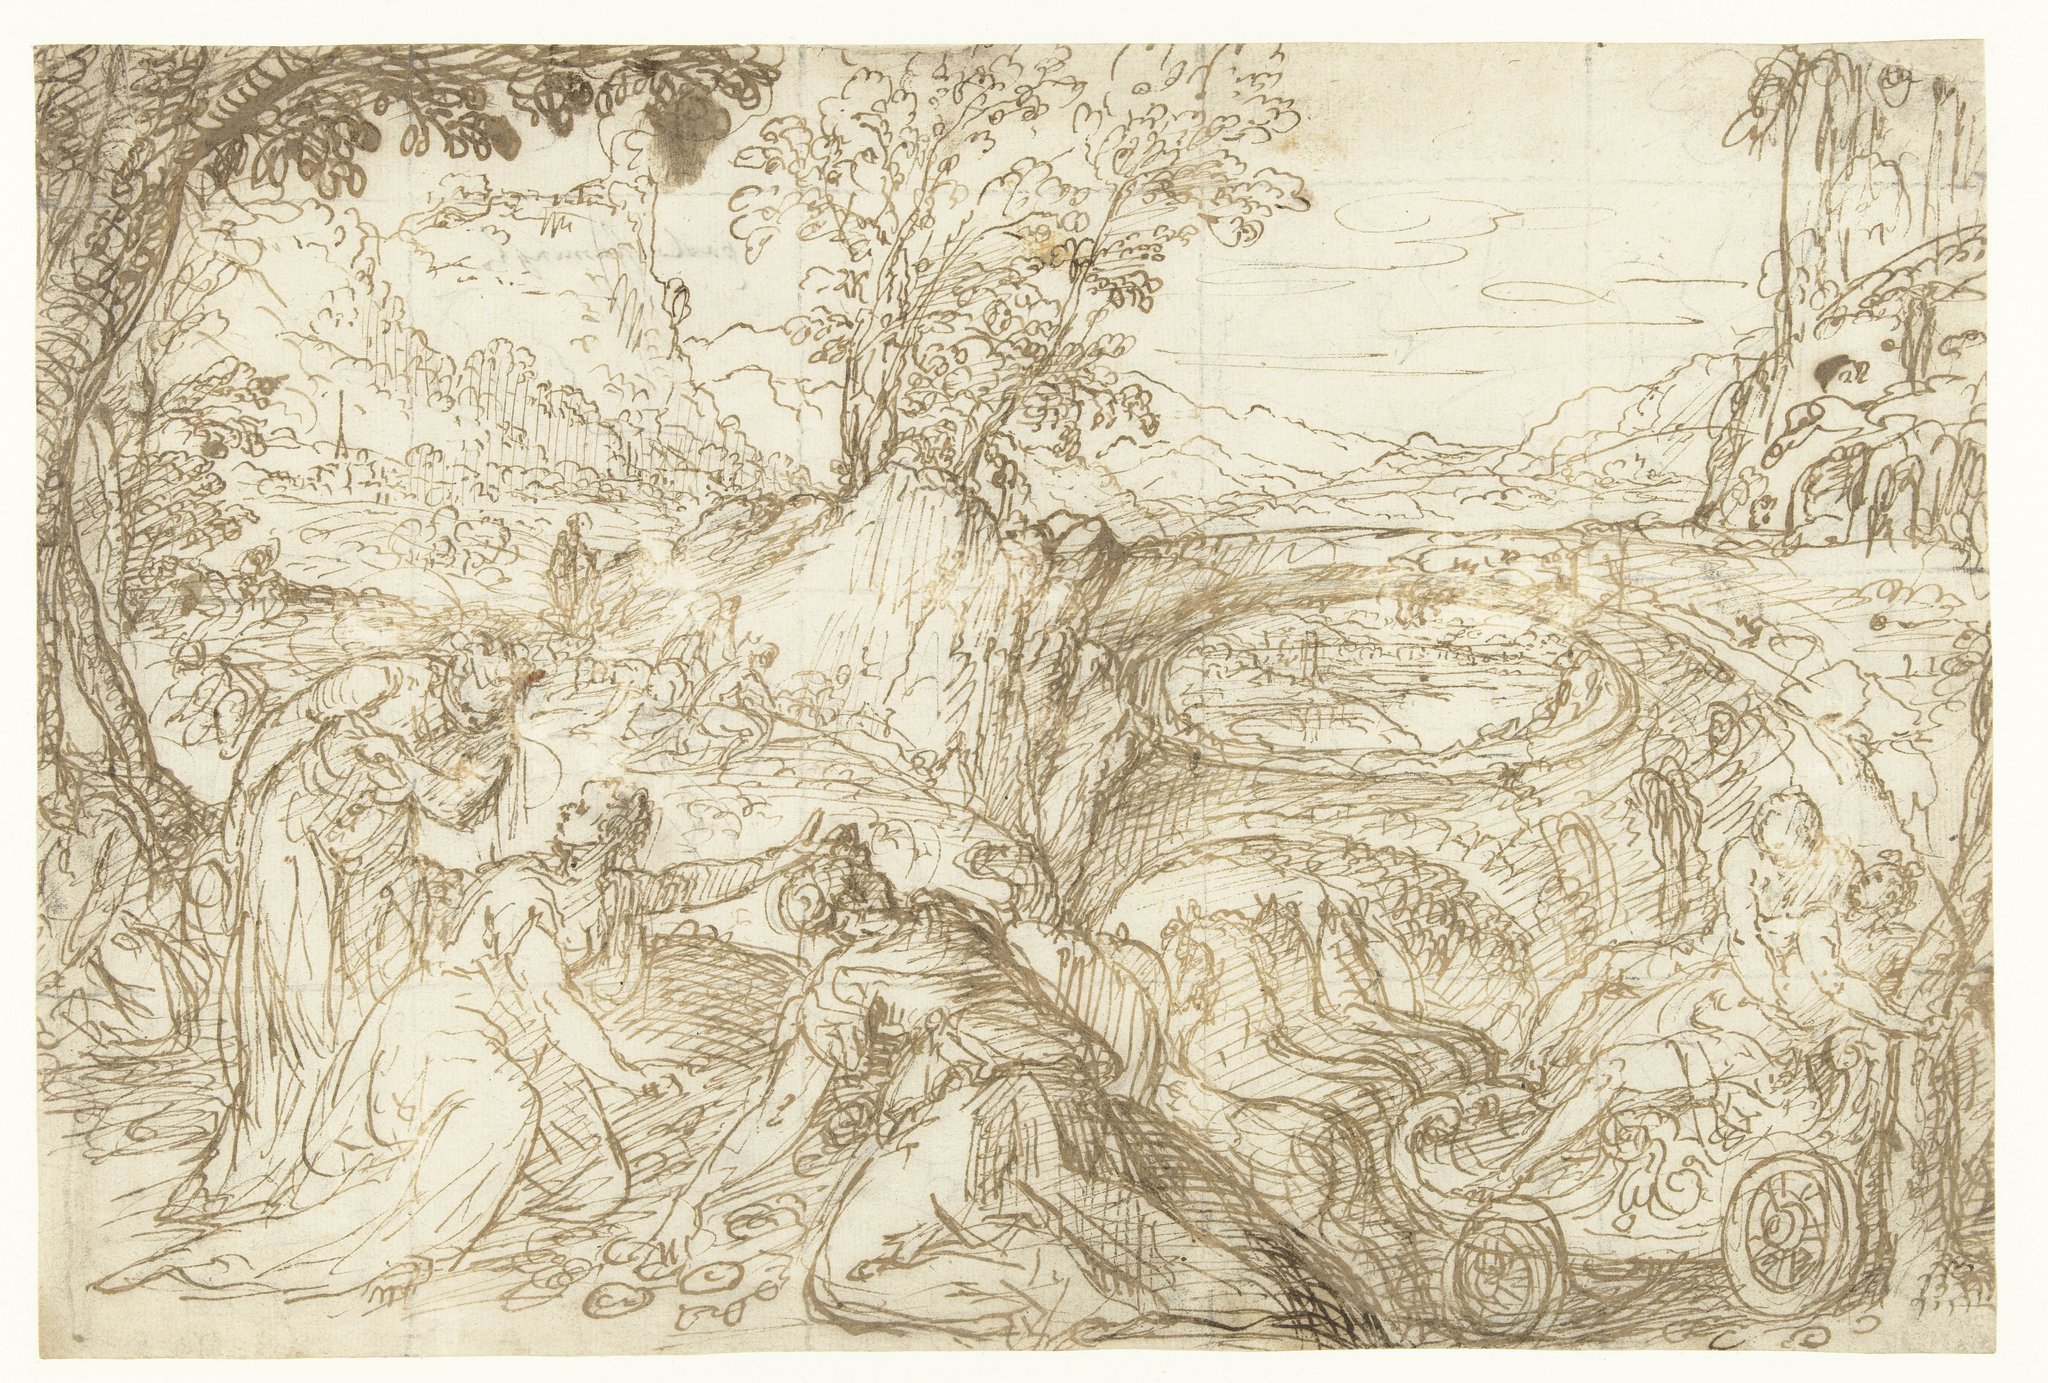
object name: drawing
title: Roof van Proserpina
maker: pauwels franck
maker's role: draughtsman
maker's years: 1540-1596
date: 1550-1596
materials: ink, paper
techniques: pen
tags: the rape of proserpina (by pluto in his chariot); possibly with diana and minerva trying to rescue her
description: Links op de voorgrond drie nimfen die bloemen plukken. Rechts wordt Proserpina door Pluto weggevoerd in zijn wagen, die wordt getrokken door vier paarden.